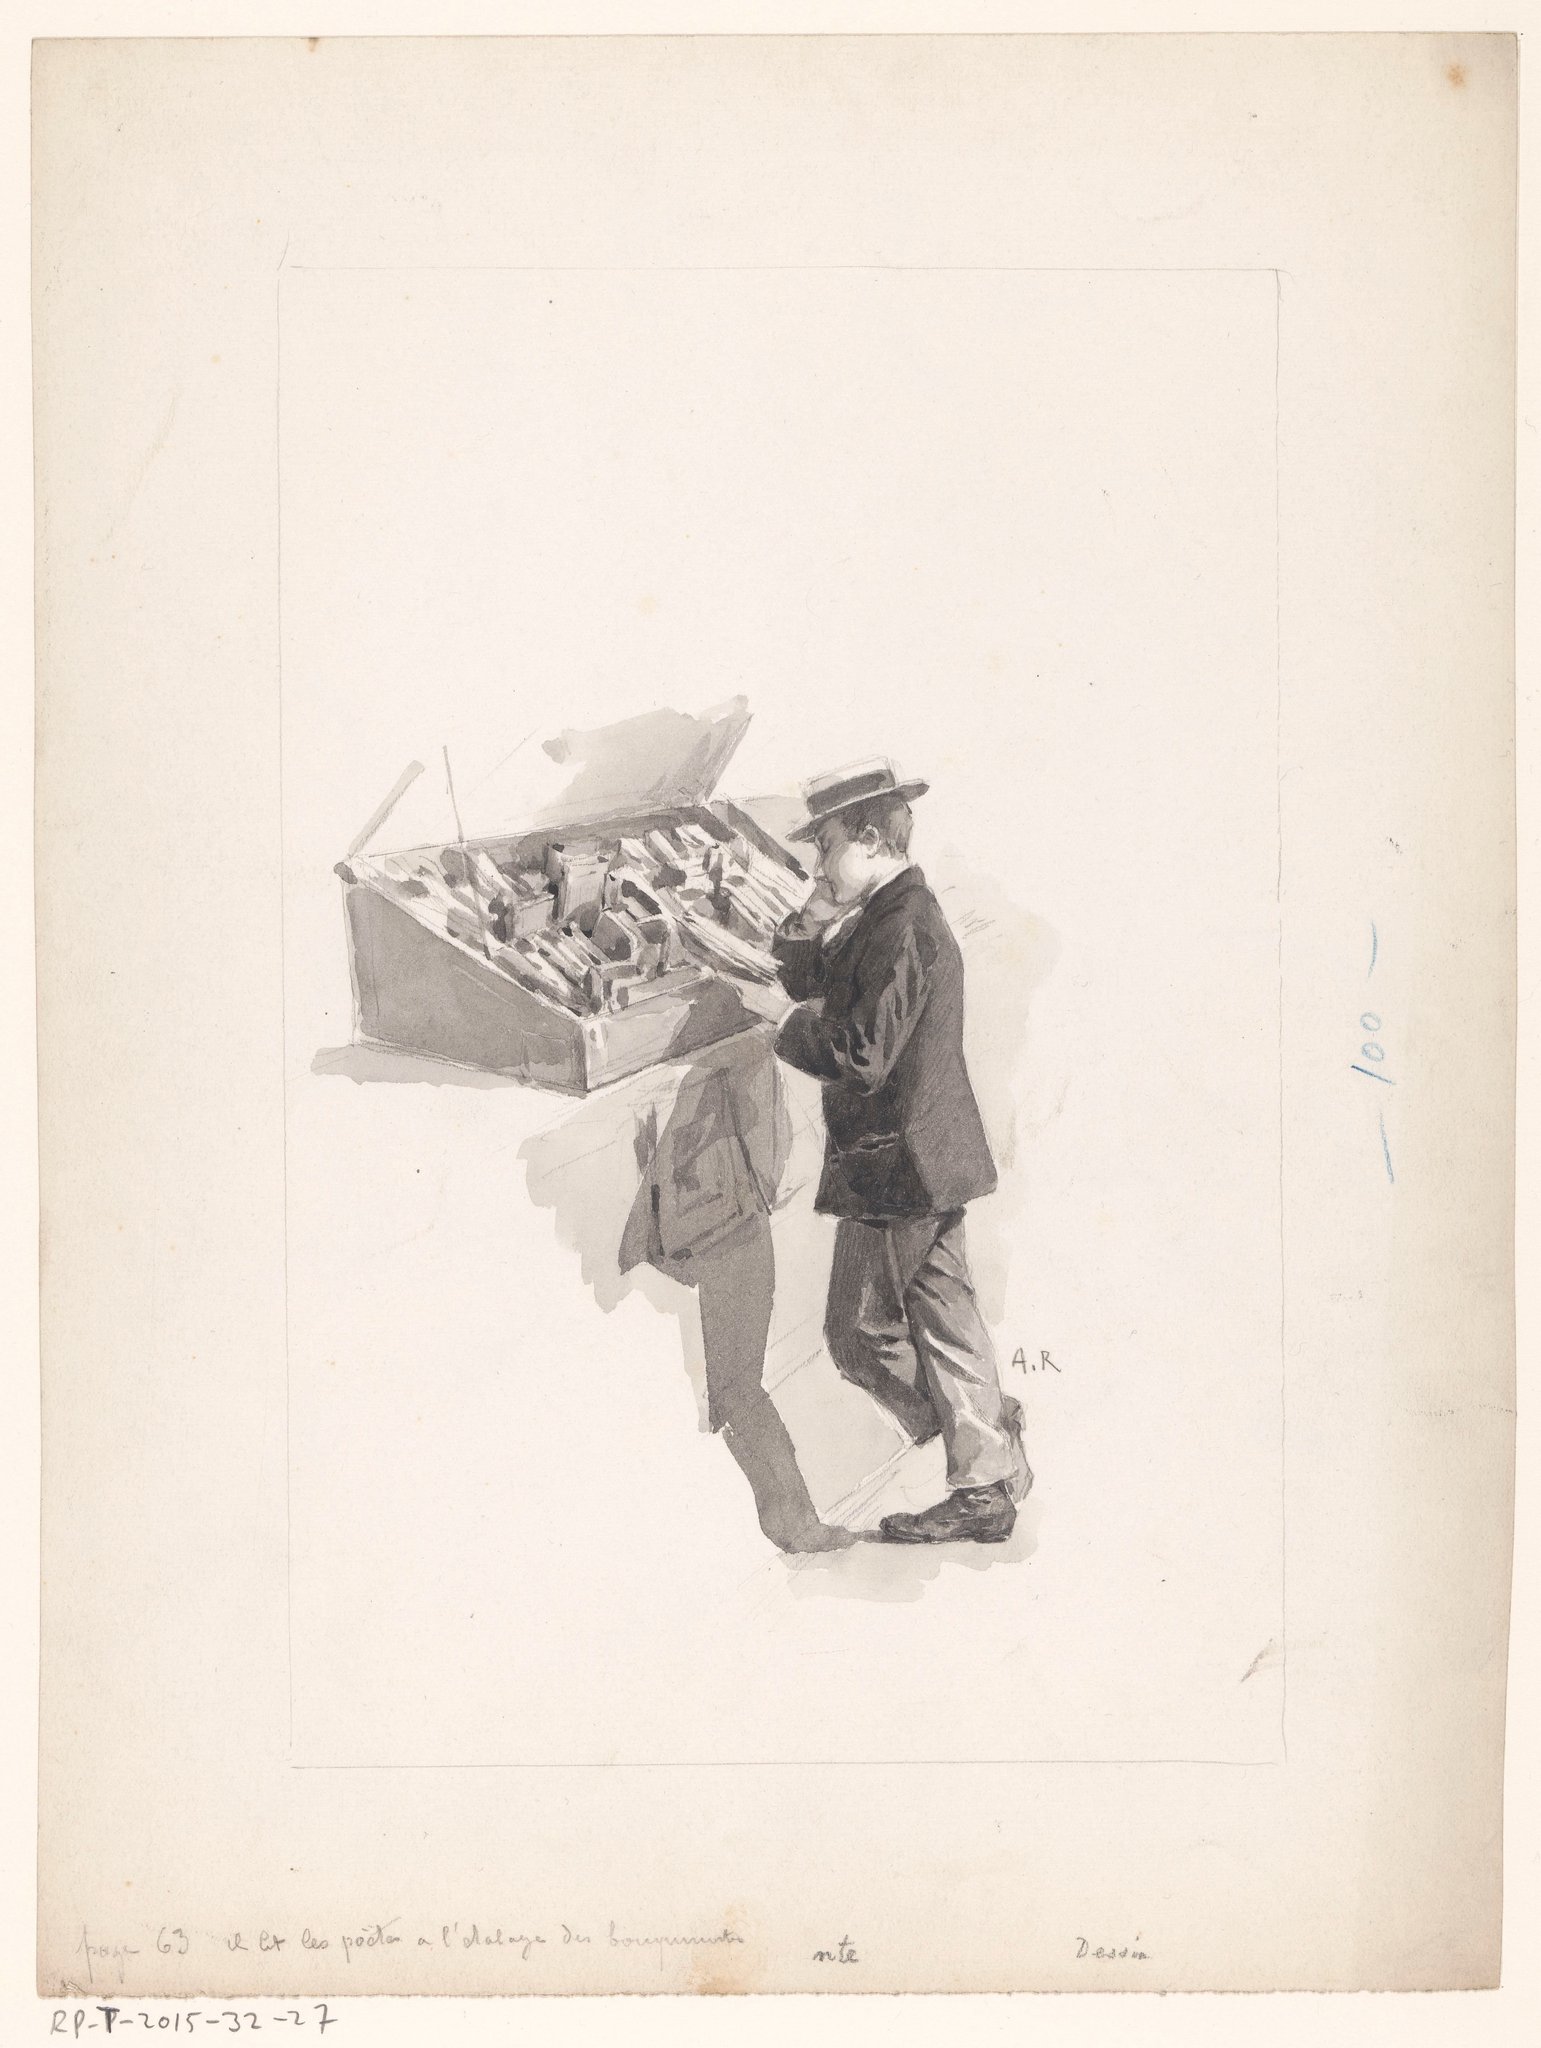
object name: drawing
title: il lit les poètes a l'etalage des bouquinistes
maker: alcide théophile robaudi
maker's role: painter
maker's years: 1850-1928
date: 1890-1928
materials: paper, pencil, watercolor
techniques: brush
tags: book-stall, kiosk, boy (child between toddler and youth), literary characters and objects, newspaper, news-sheet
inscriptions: annotation: ‘page 63 il lit les poètes a l'etalage des bouquinistes’, collector's mark: Lugt 2228, collector's mark: Lugt 4779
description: Ontwerp voor een boekillustratie voor: 'Toute une jeunesse' door François Coppée, voor het eerst uitgegeven in 1890.